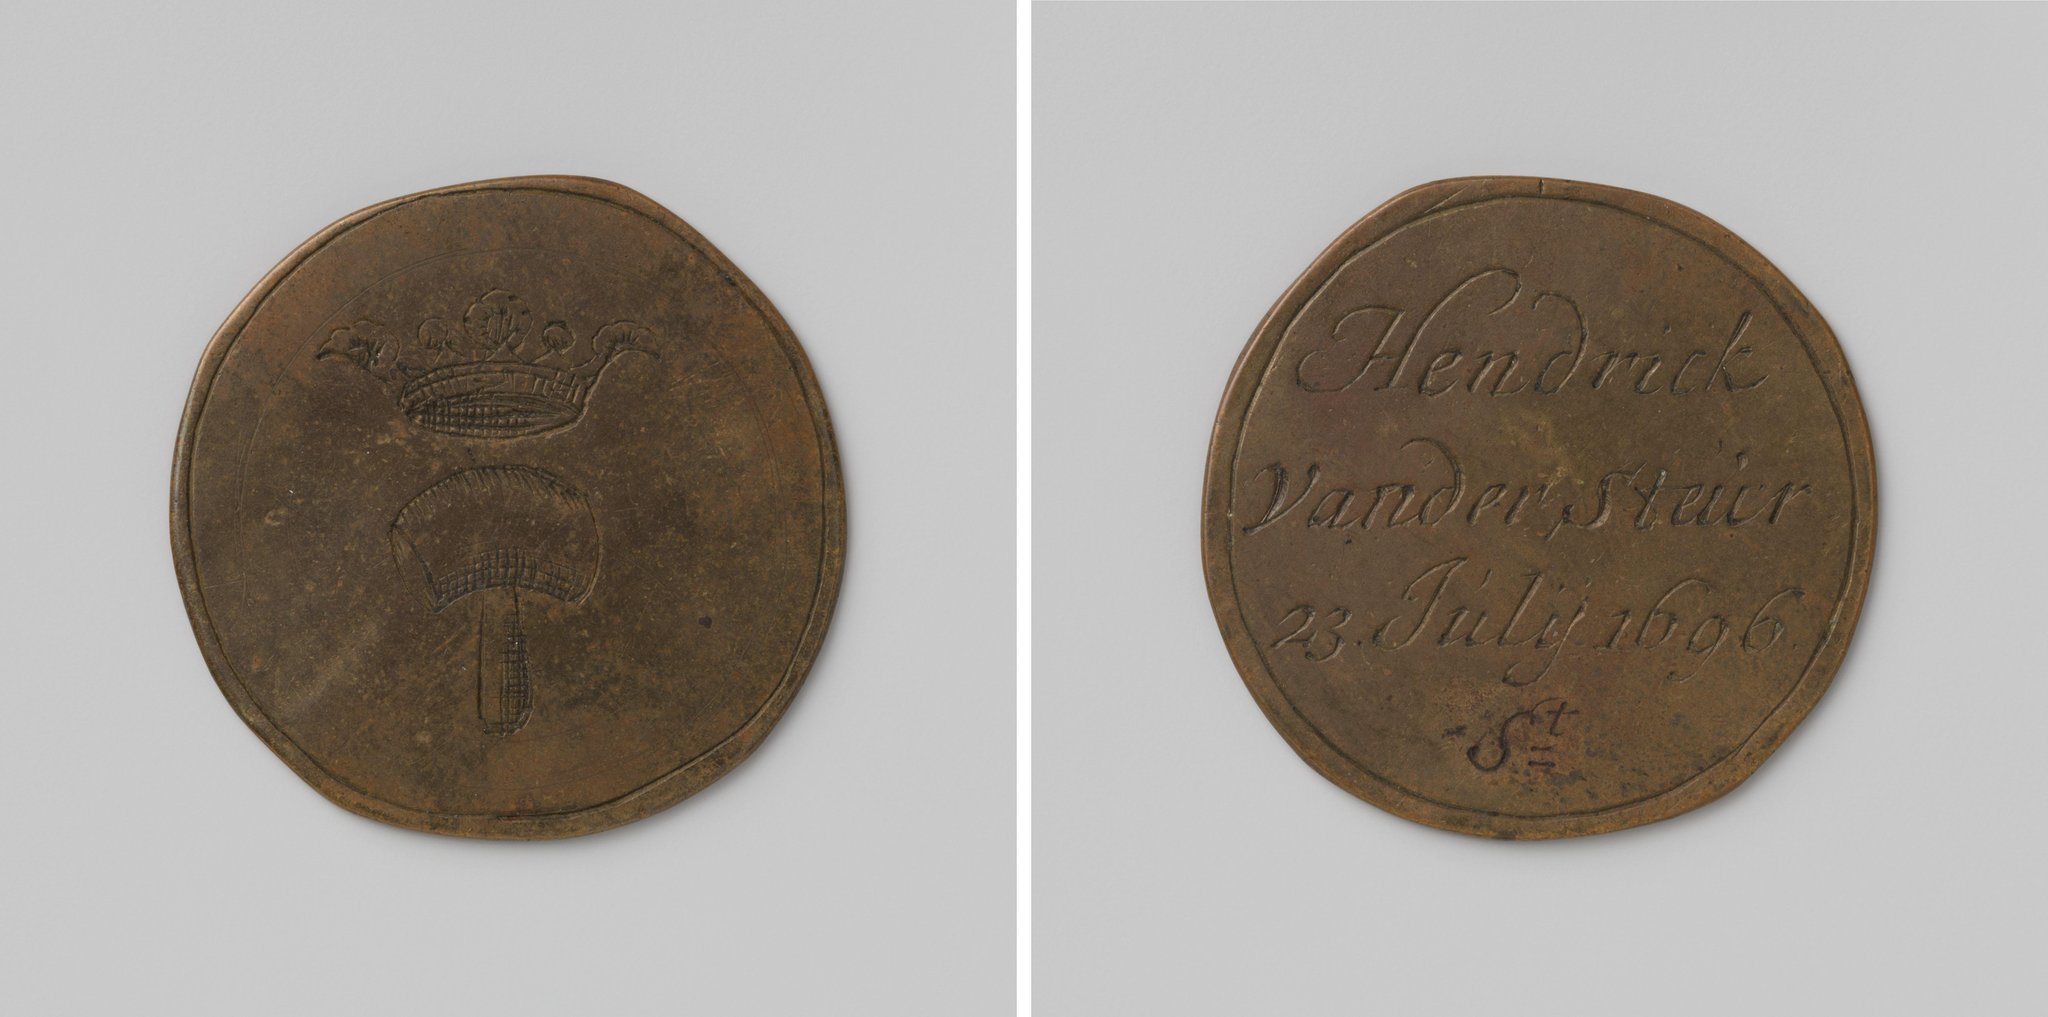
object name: medal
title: Metselaars-, steenhouwers-, leidekkers-, loodgieters- en pompenmakersgilde van Amsterdam, gildepenning van Hendrick van der Steur, steenhouwer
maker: Anonymous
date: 1696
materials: brass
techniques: engraving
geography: amsterdam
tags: amsterdam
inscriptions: : ‘Hendrick van der Steur 23 july 1696 St’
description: Messing penning. Voorzijde: gekroonde steenhouwershamer. Keerzijde: opschrift.